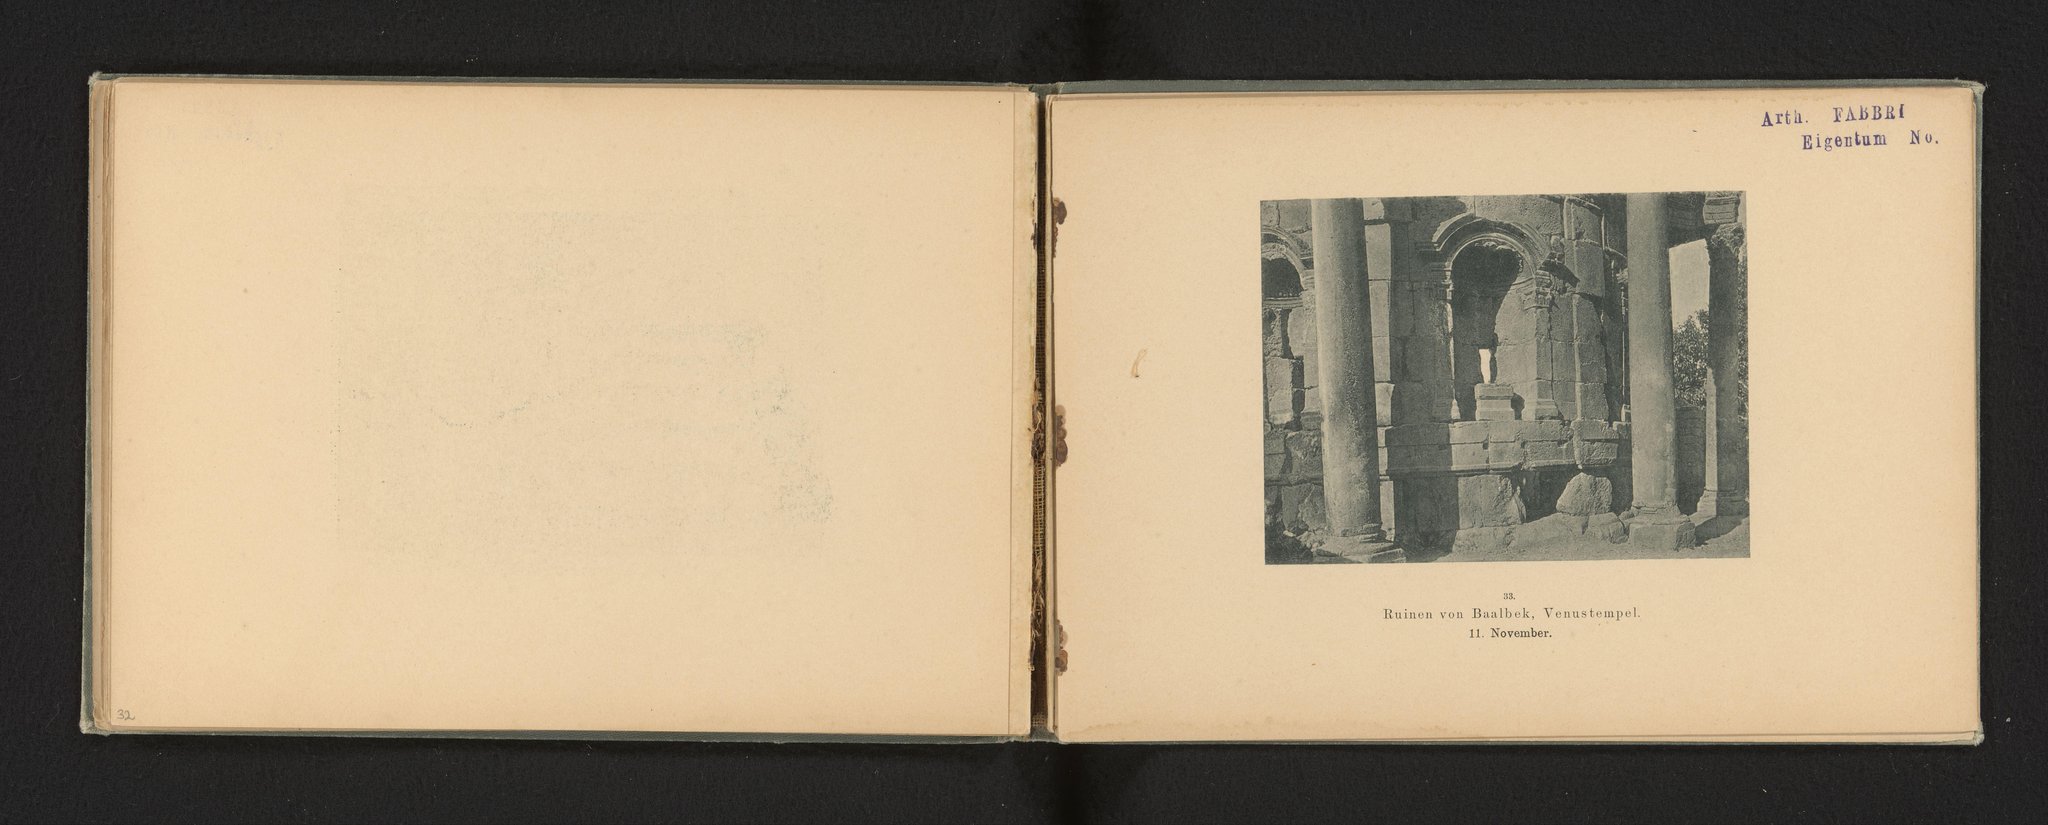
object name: photomechanical print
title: Ruinen von Baalbek, Venustempel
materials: paper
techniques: photograph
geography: baalbek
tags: ruin of a building ~ architecture, (story of) venus (aphrodite), temple, shrine ~ roman religion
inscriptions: collector's mark: ‘Arth. FABBRI/ Eigentum No.’, number: ‘33.’